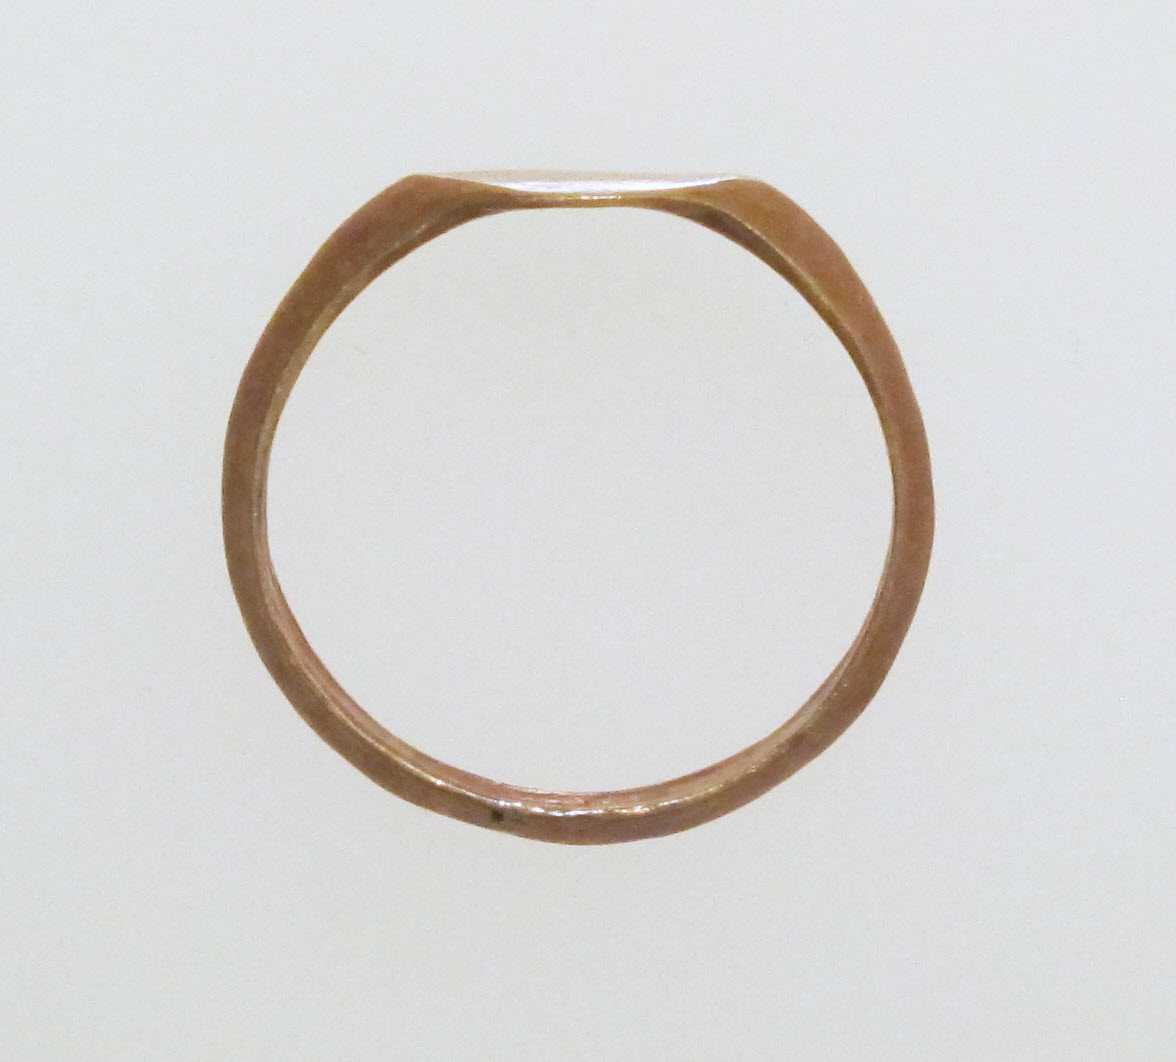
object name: ring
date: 7000 BCE-330 CE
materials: gold